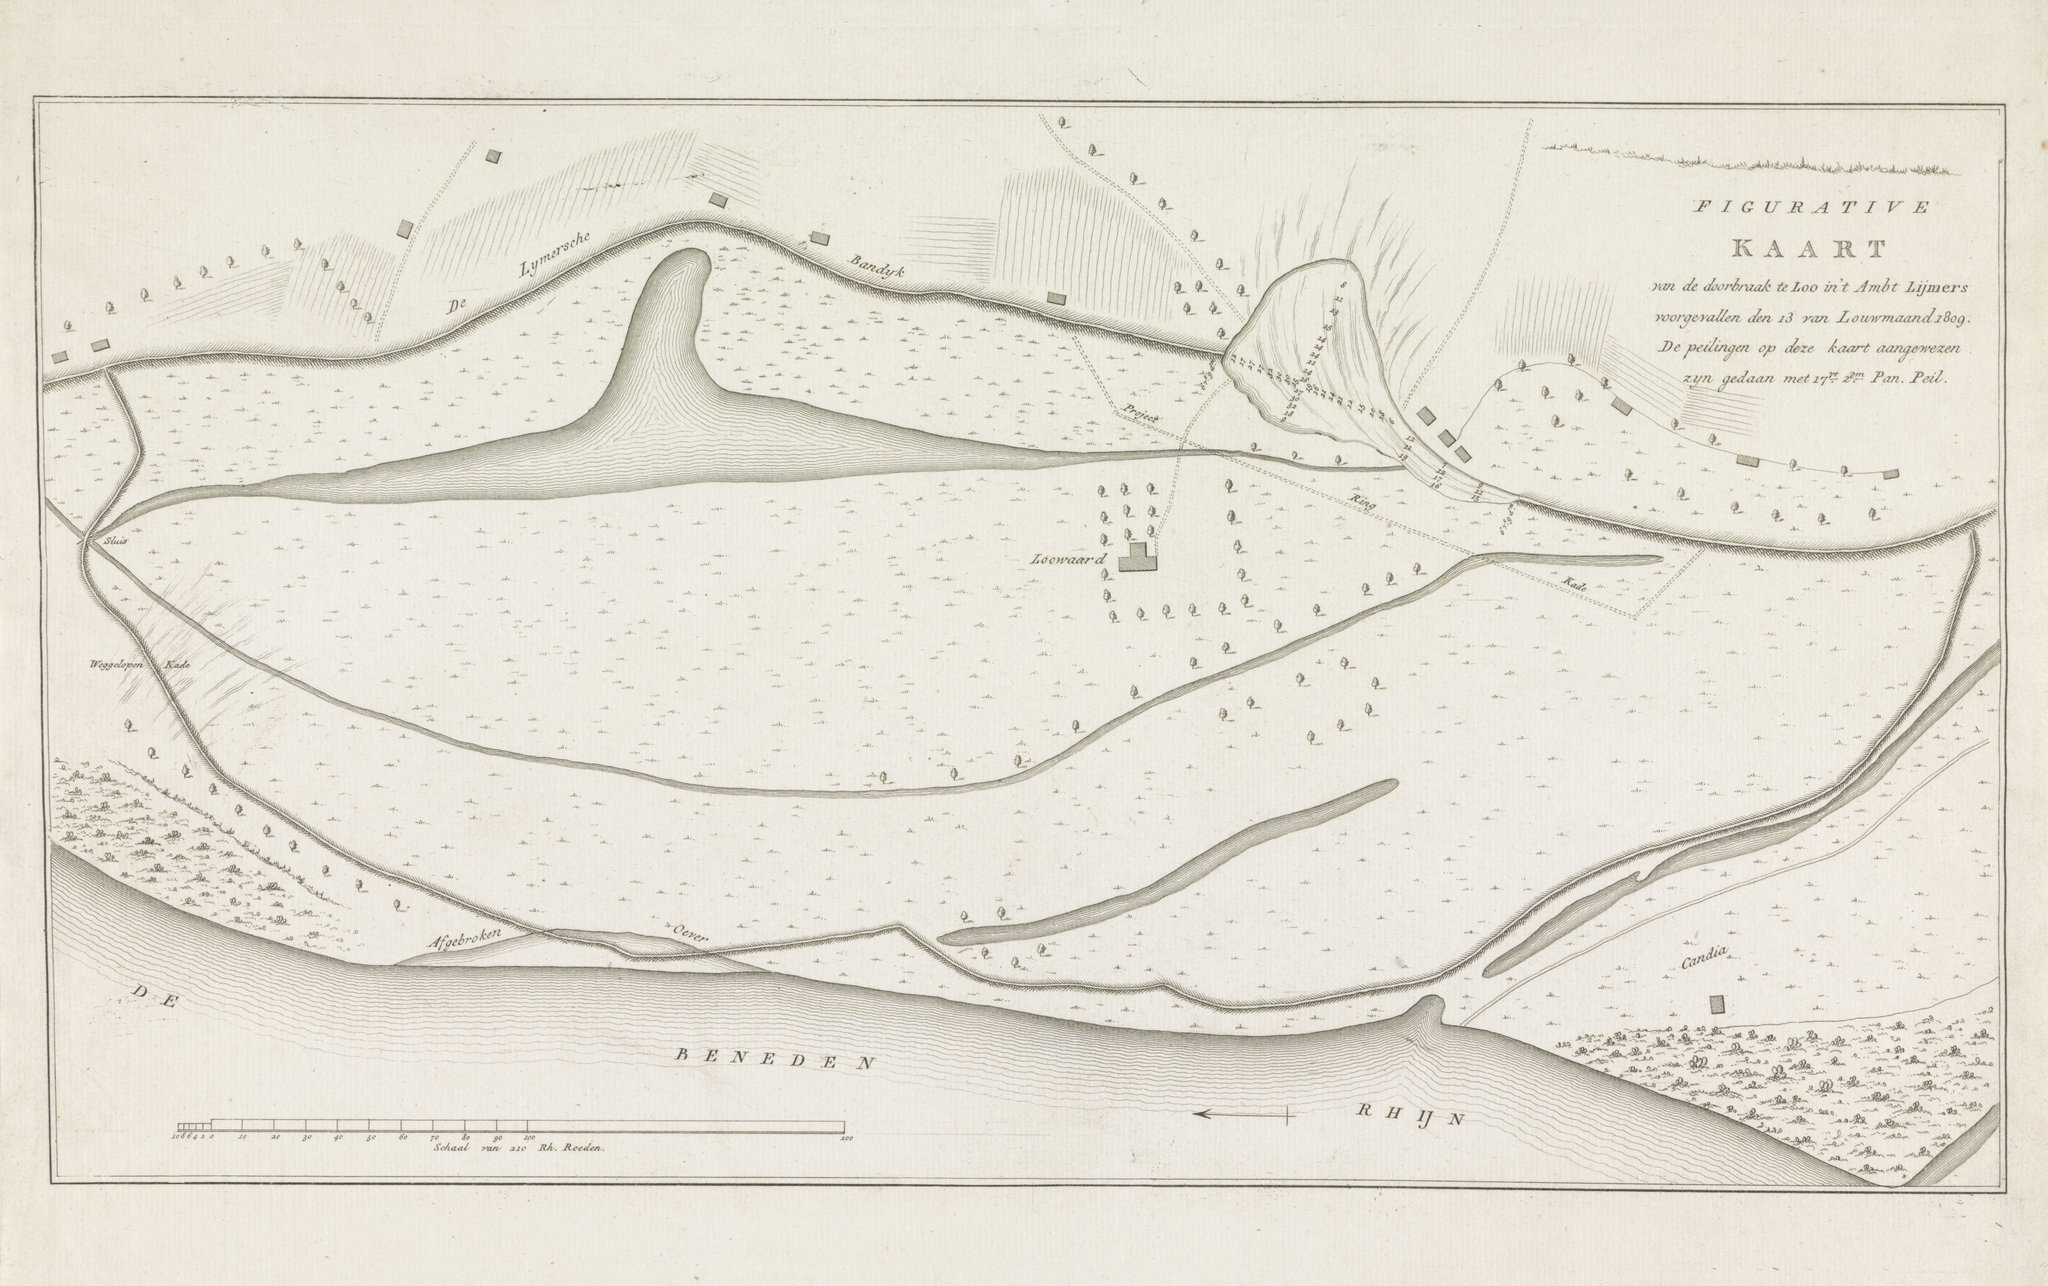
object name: map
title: Kaart van dijkdoorbraak te Loo, 1809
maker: Anonymous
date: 1809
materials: paper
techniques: engraving, etching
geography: netherlands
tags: dike-break, maps of separate countries or regions, lower rhine region, gelderland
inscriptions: collector's mark: Lugt 2228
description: Gebruikt als illustratie in: Hendrik Ewijk. Geschiedkundig verslag der dijkbreuken en overstroomingen, langs de rivieren in het Koningrijk Holland, voorgevallen in louwmaand MDCCCIX. 3 dln. Amsterdam: Johannes Allart en Jacobus Ruys, 1809.